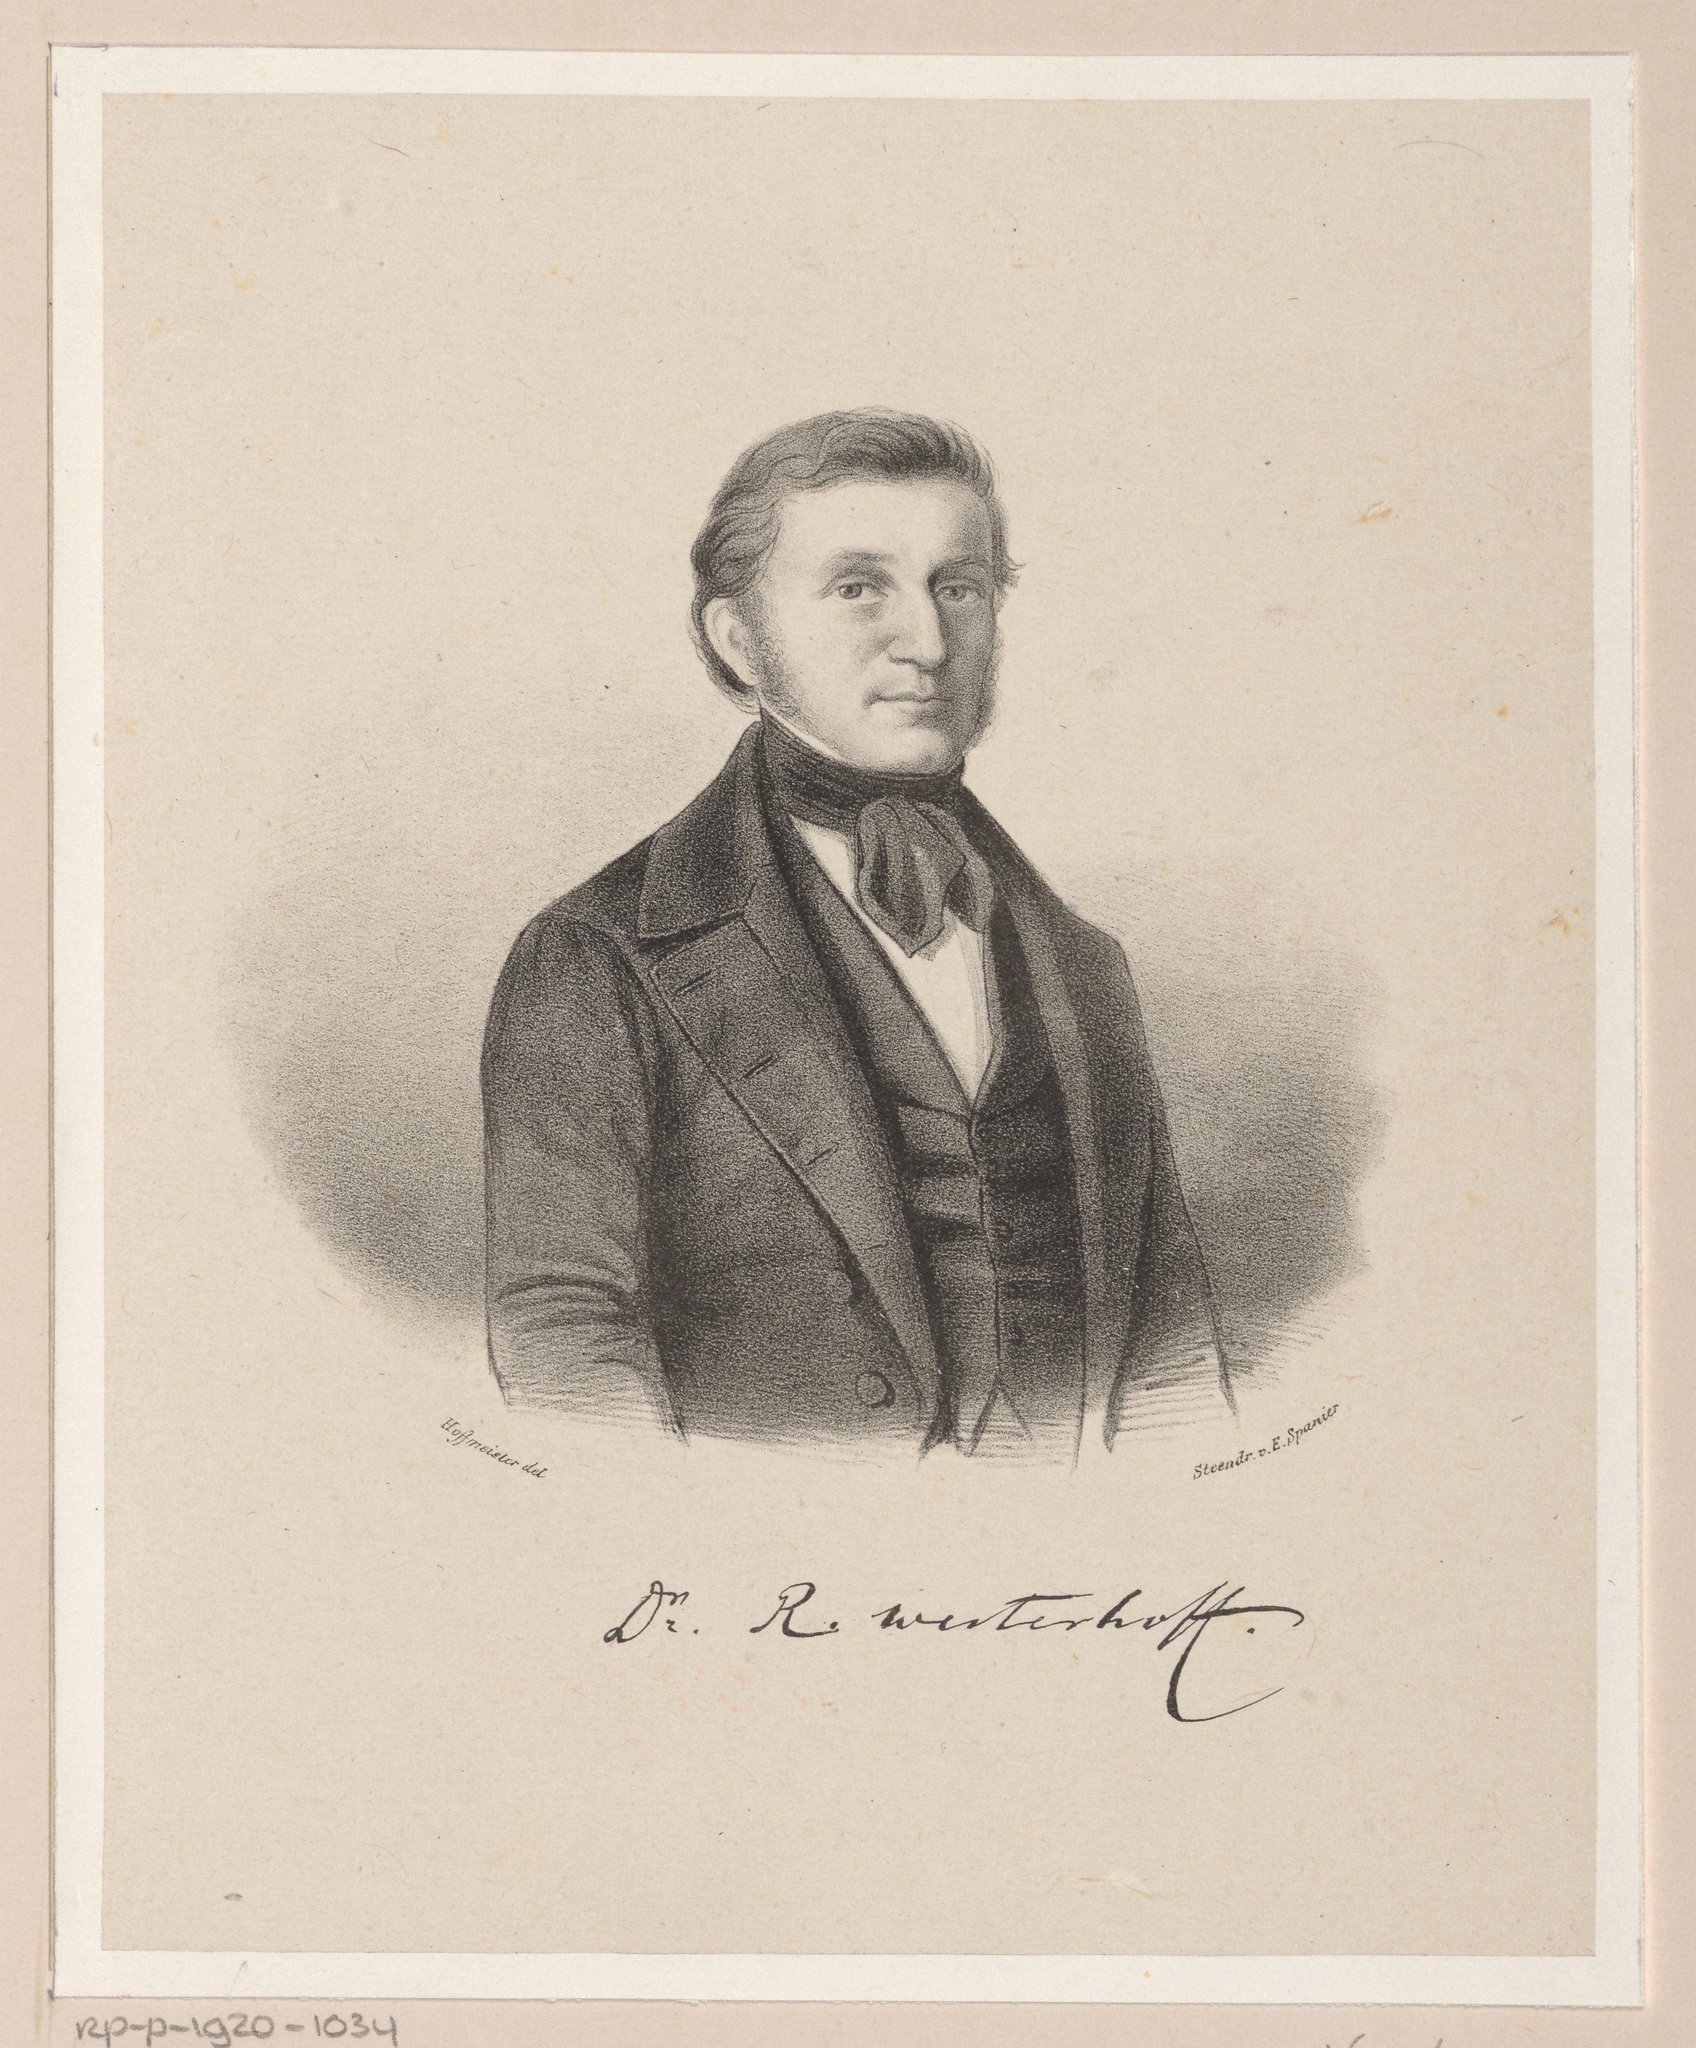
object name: print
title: Portret van Rembertus Westerhoff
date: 1843-1863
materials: paper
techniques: lithograph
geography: the hague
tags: politician, physicist, historical persons, politician, e.g. party leader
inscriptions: collector's mark: Lugt 2228